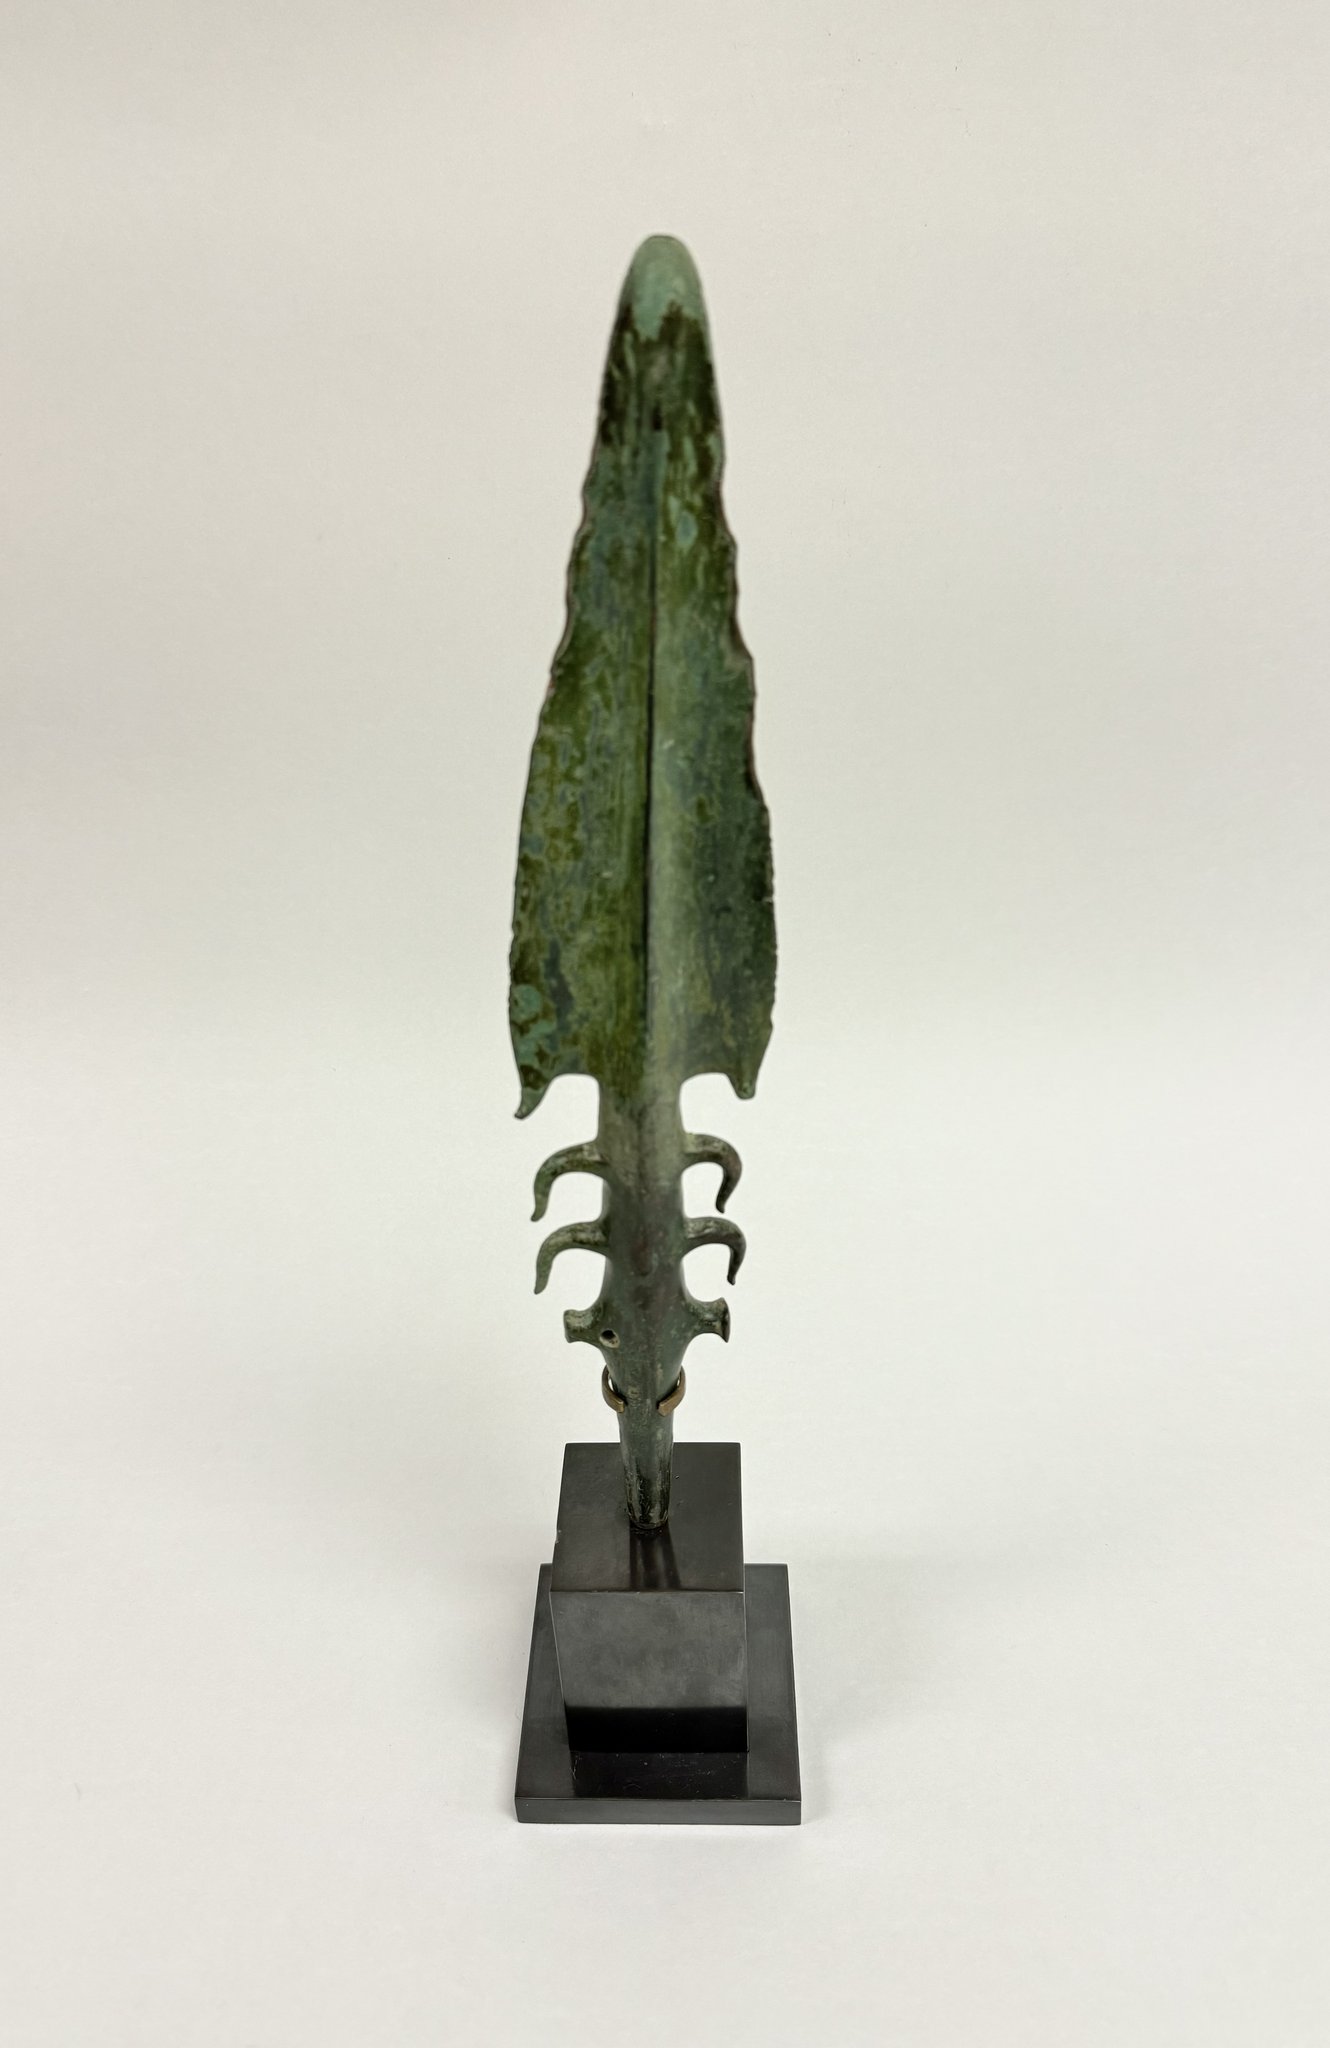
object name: harpoon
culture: indian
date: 1500-500 BCE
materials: copper